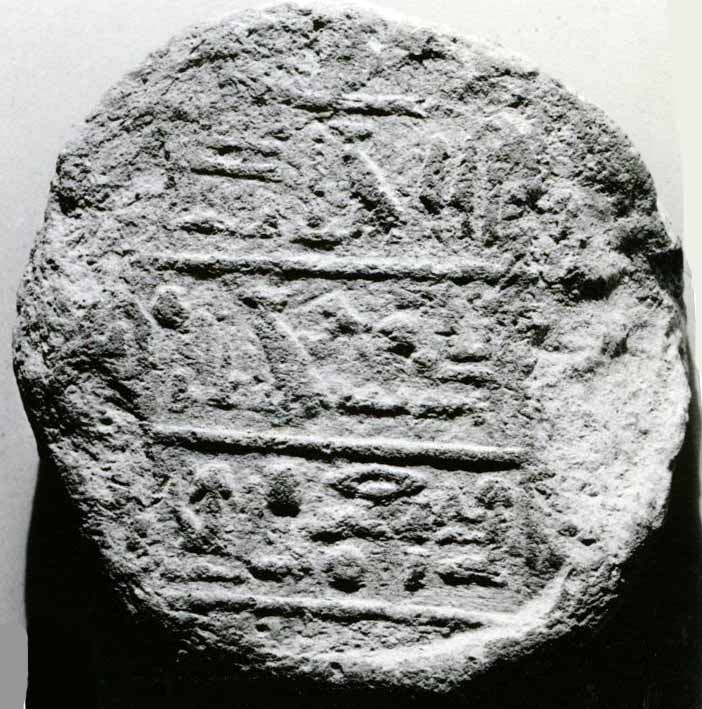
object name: cone, penre, circular impression, medjay, charioteer, kharu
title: Funerary Cone of the Chief of the Madjay Penre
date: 1279-1213 BCE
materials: pottery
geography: egypt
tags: hieroglyphs